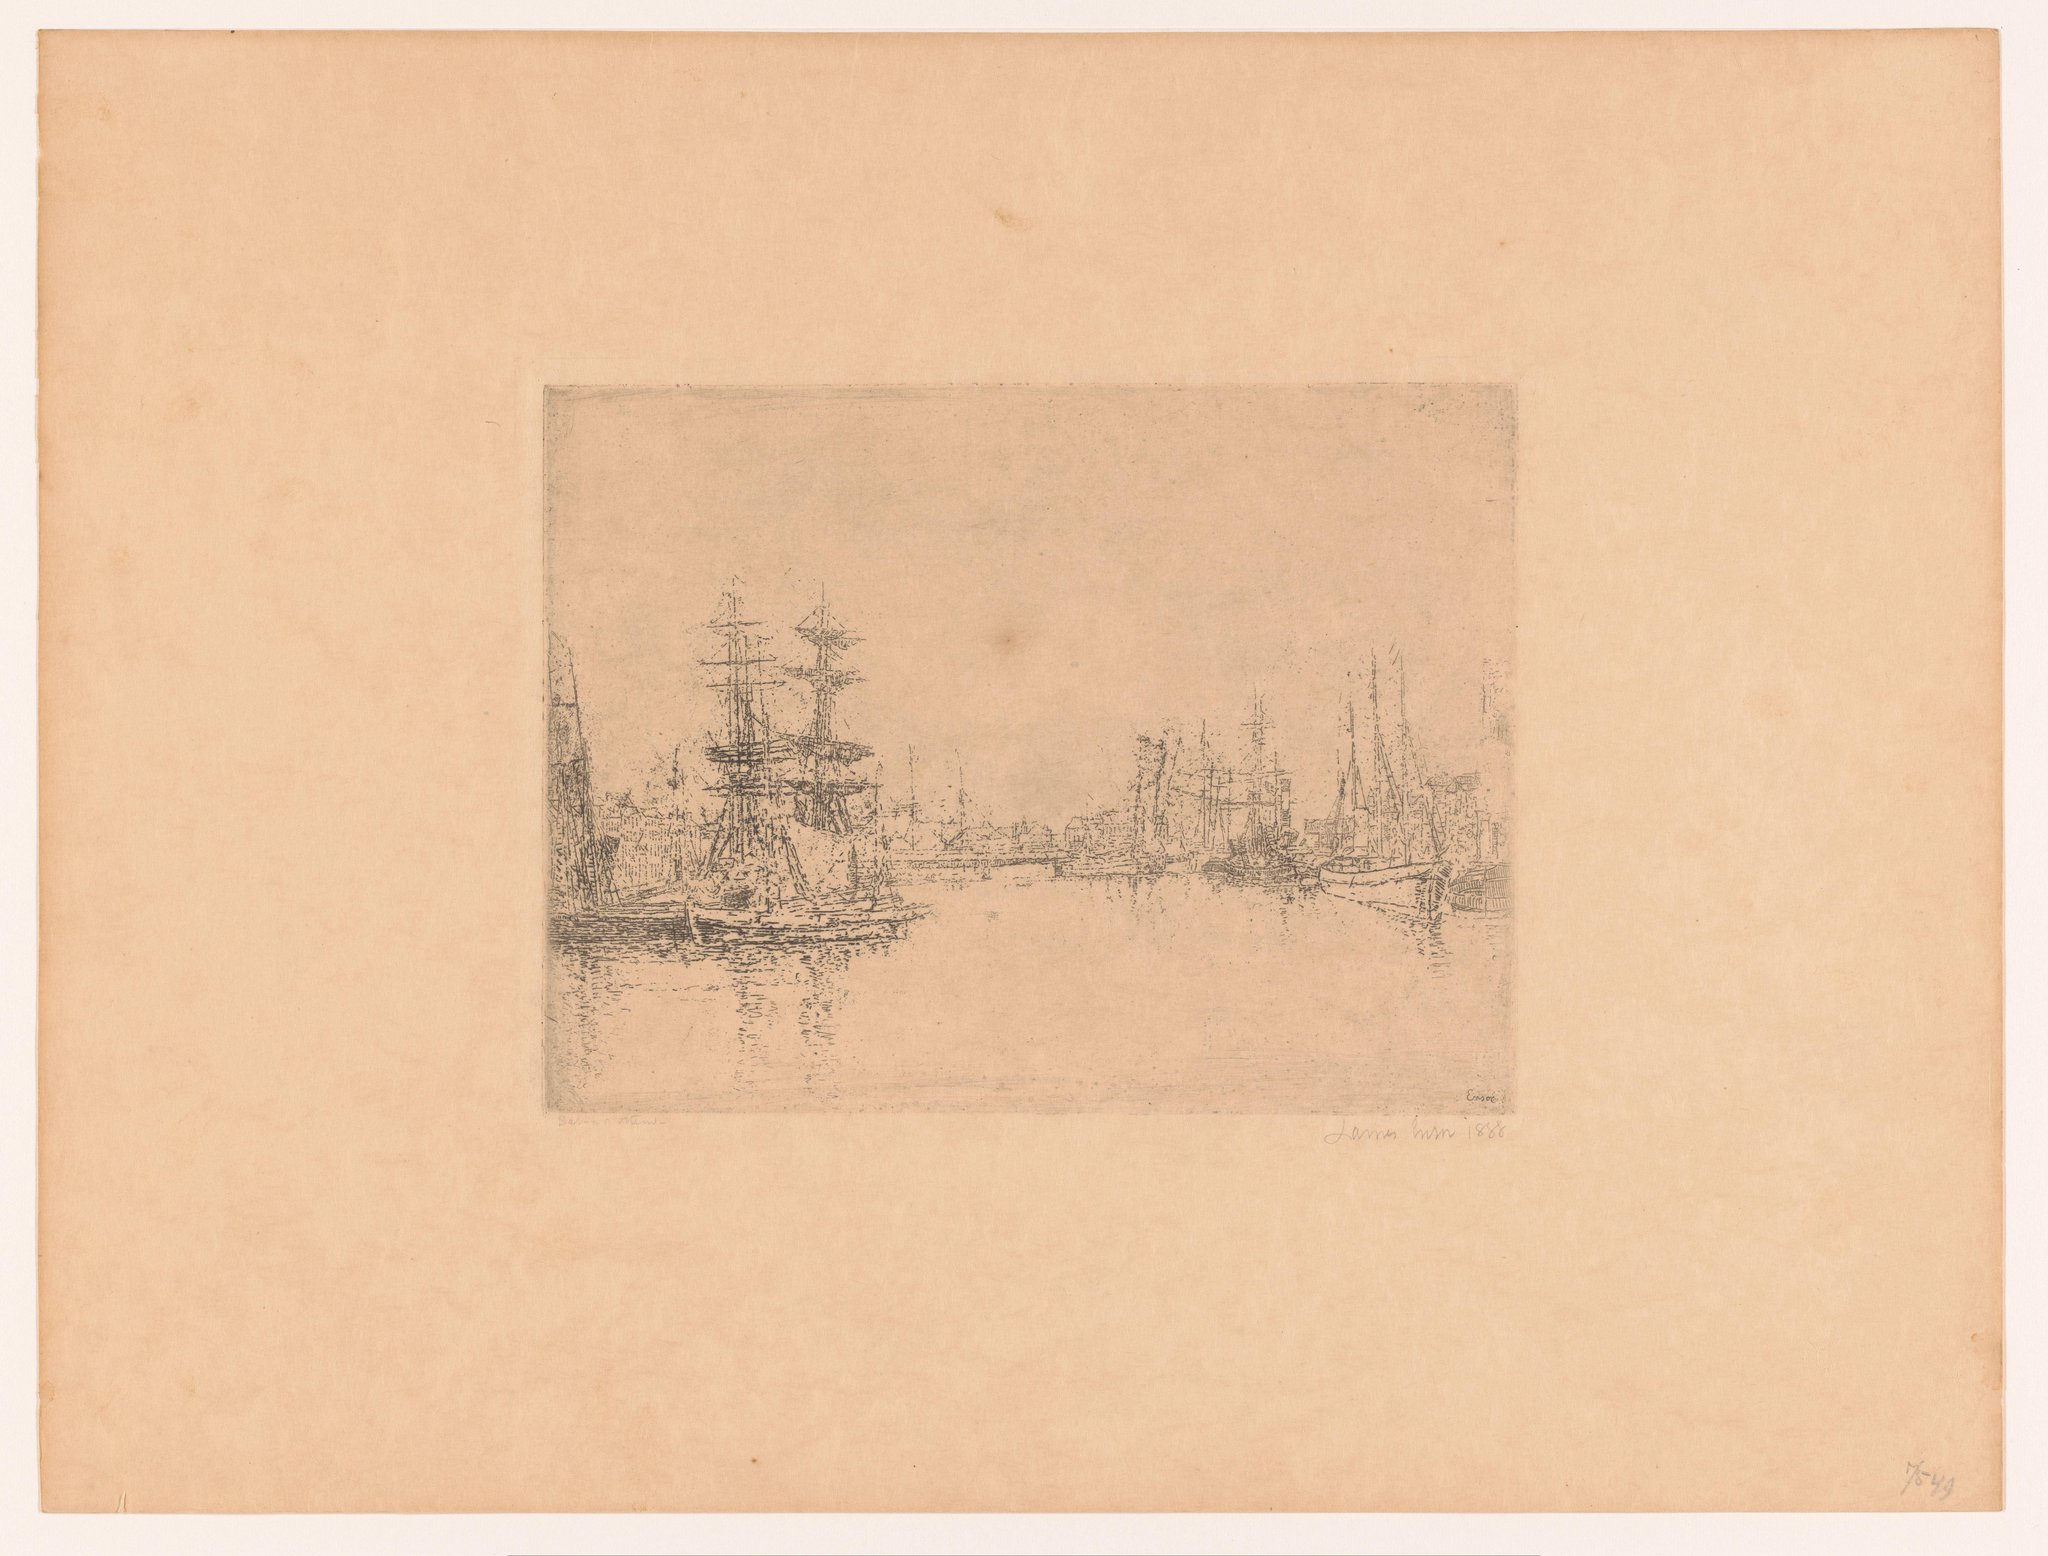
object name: print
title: Le grand bassin à Ostende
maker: james ensor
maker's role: print maker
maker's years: 1860-1949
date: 1888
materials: paper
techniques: etching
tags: harbour, ship bound for the harbour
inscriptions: collector's mark: Lugt 2228, collector's mark: Lugt 2760